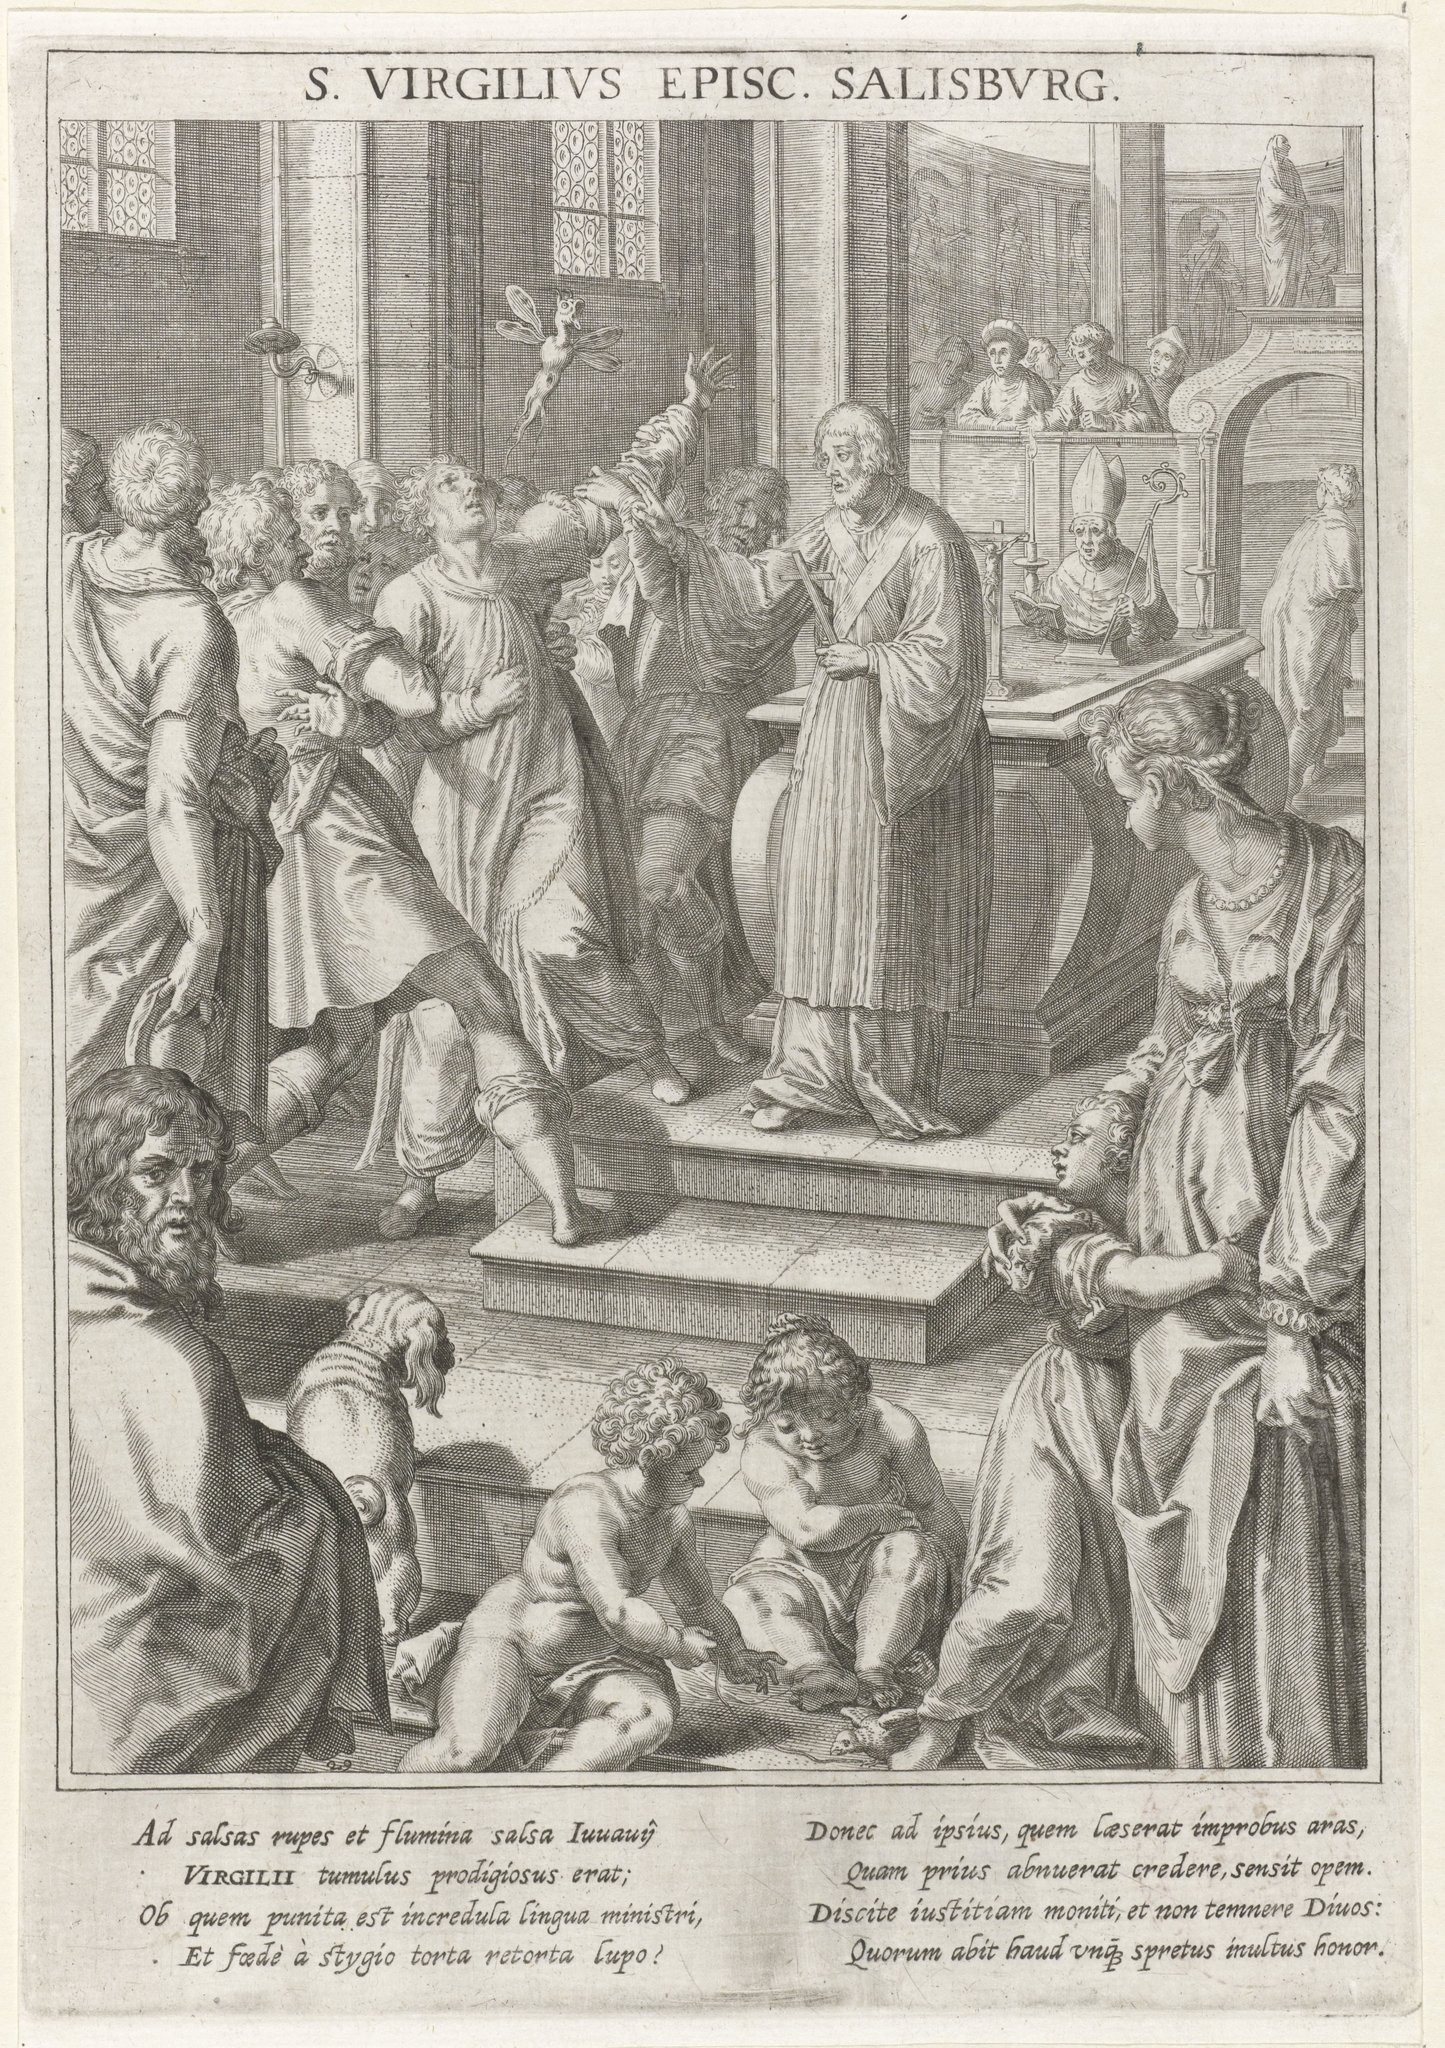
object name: print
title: Heilige Virgilius drijft vanuit zijn graf een duivel uit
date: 1615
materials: paper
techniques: engraving, etching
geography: munich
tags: the devil or demon leaving the body, e.g. through the mouth, male saints (with name), devils in the form of (fabulous) animals, grave, tomb, interior of church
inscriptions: collector's mark: Lugt 240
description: Het graf van de H. Virgilius in de kerk van Salzburg. Een priester voor het graf zegent een man en drijft met behulp van de H. Virgilius een duivel bij hem uit. De prent heeft een Latijns onderschrift en is de 29ste prent van een 60-delige serie met als onderwerp de heiligen van Beieren.